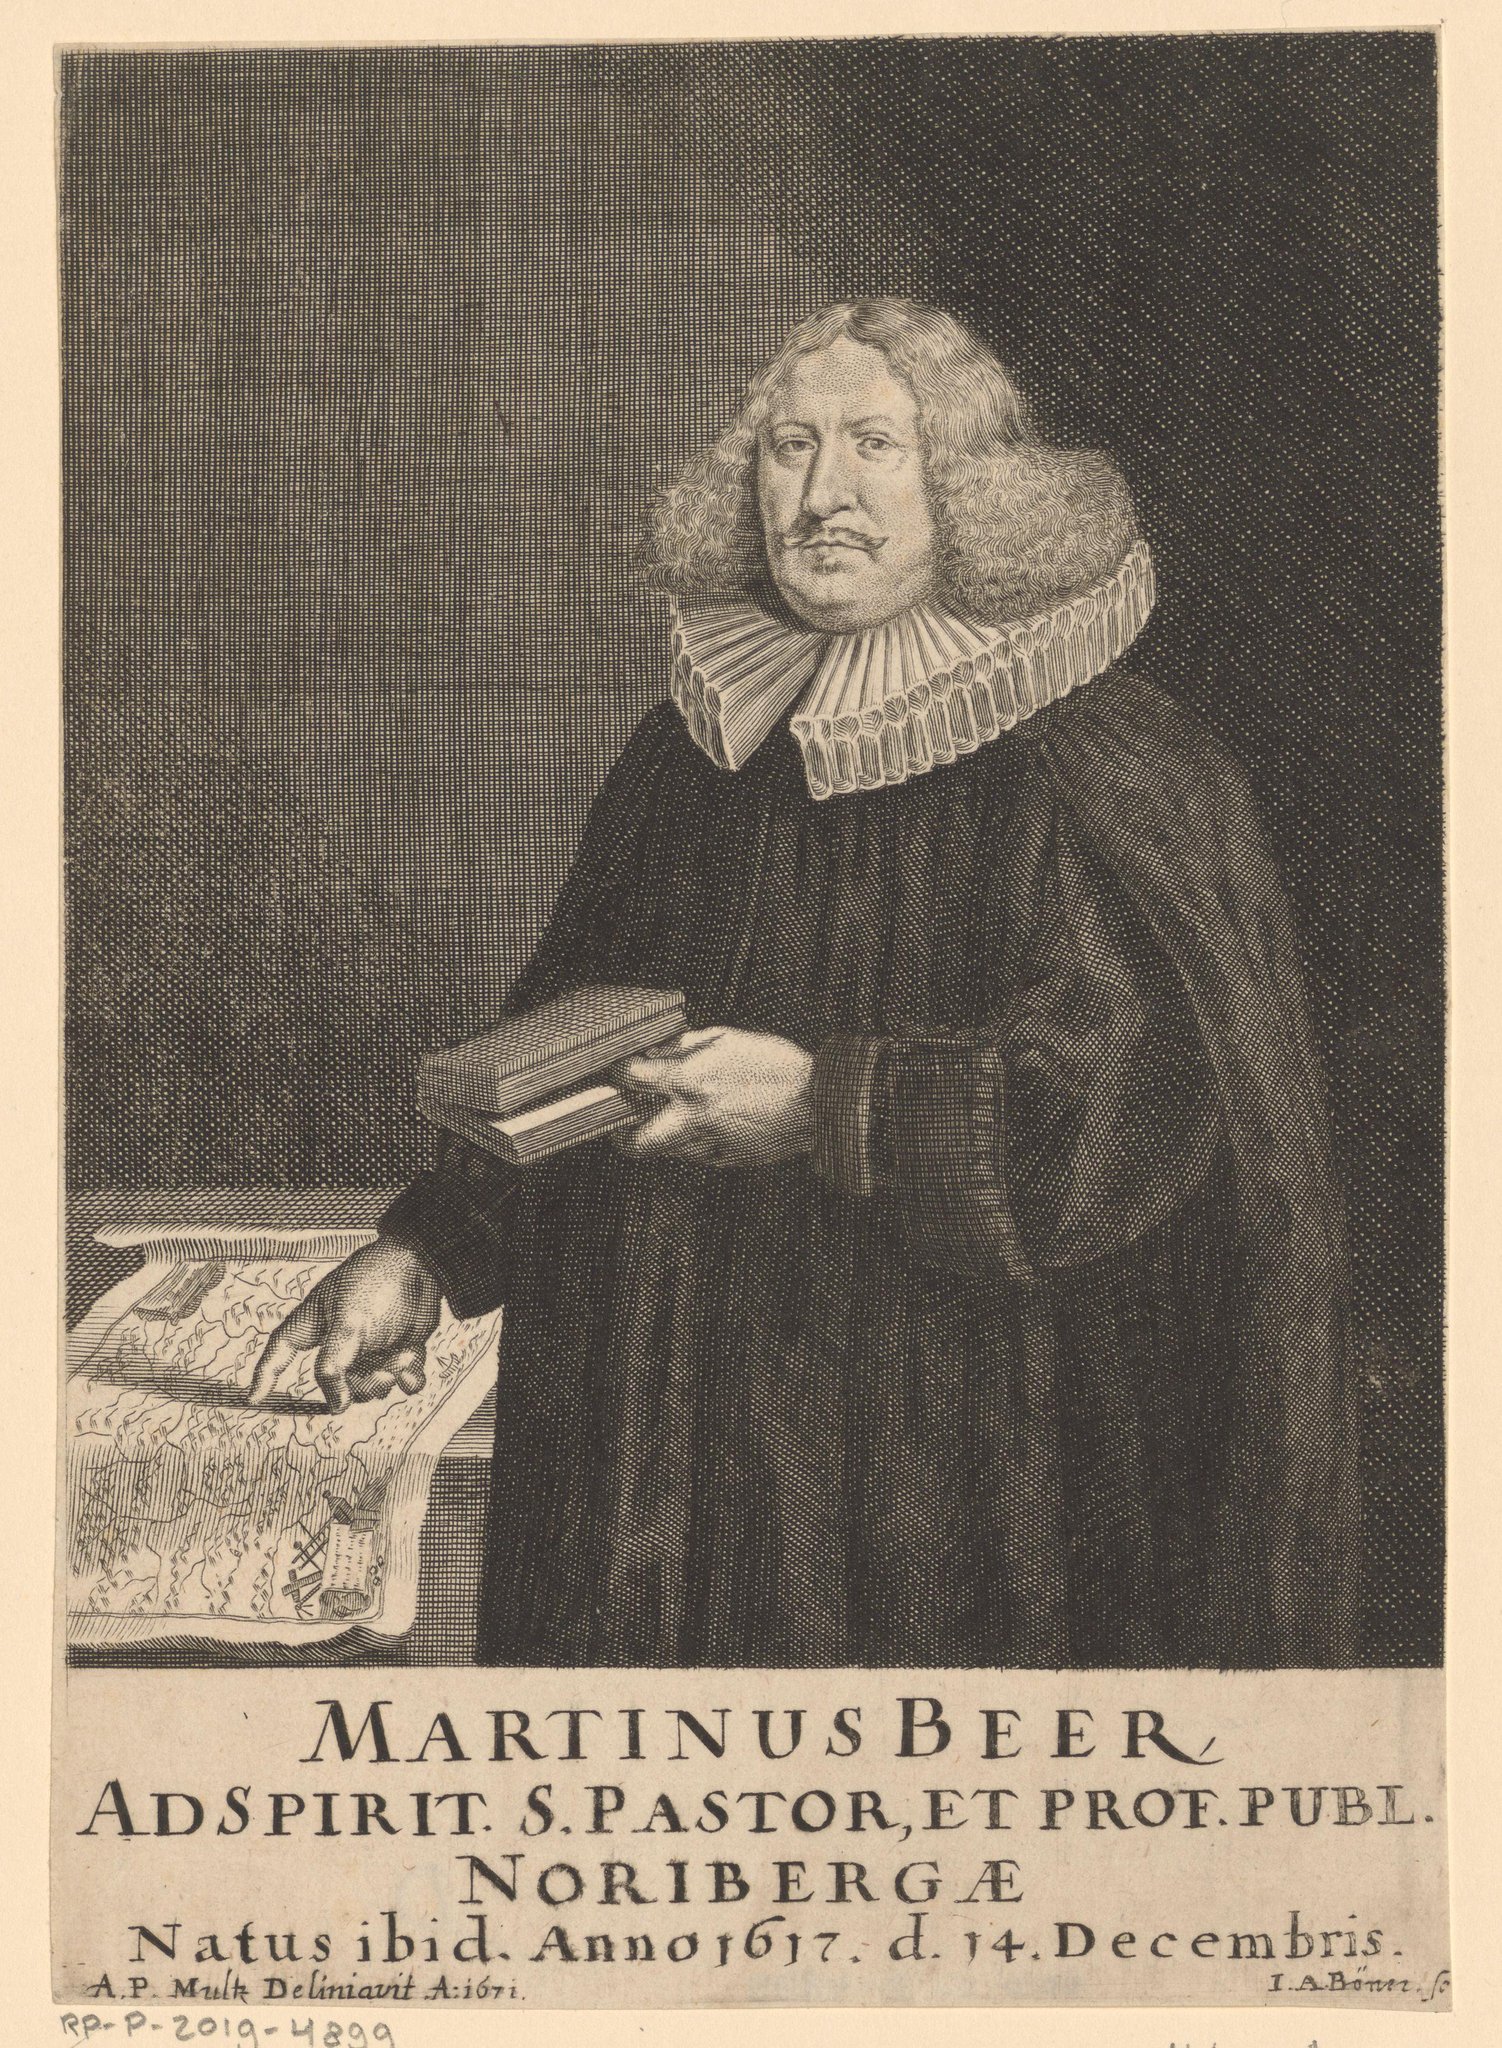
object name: print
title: Portret van Martin Beer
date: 1671-1720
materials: paper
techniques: engraving, etching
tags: theologian, maps, atlases, historical persons, book, studying a map